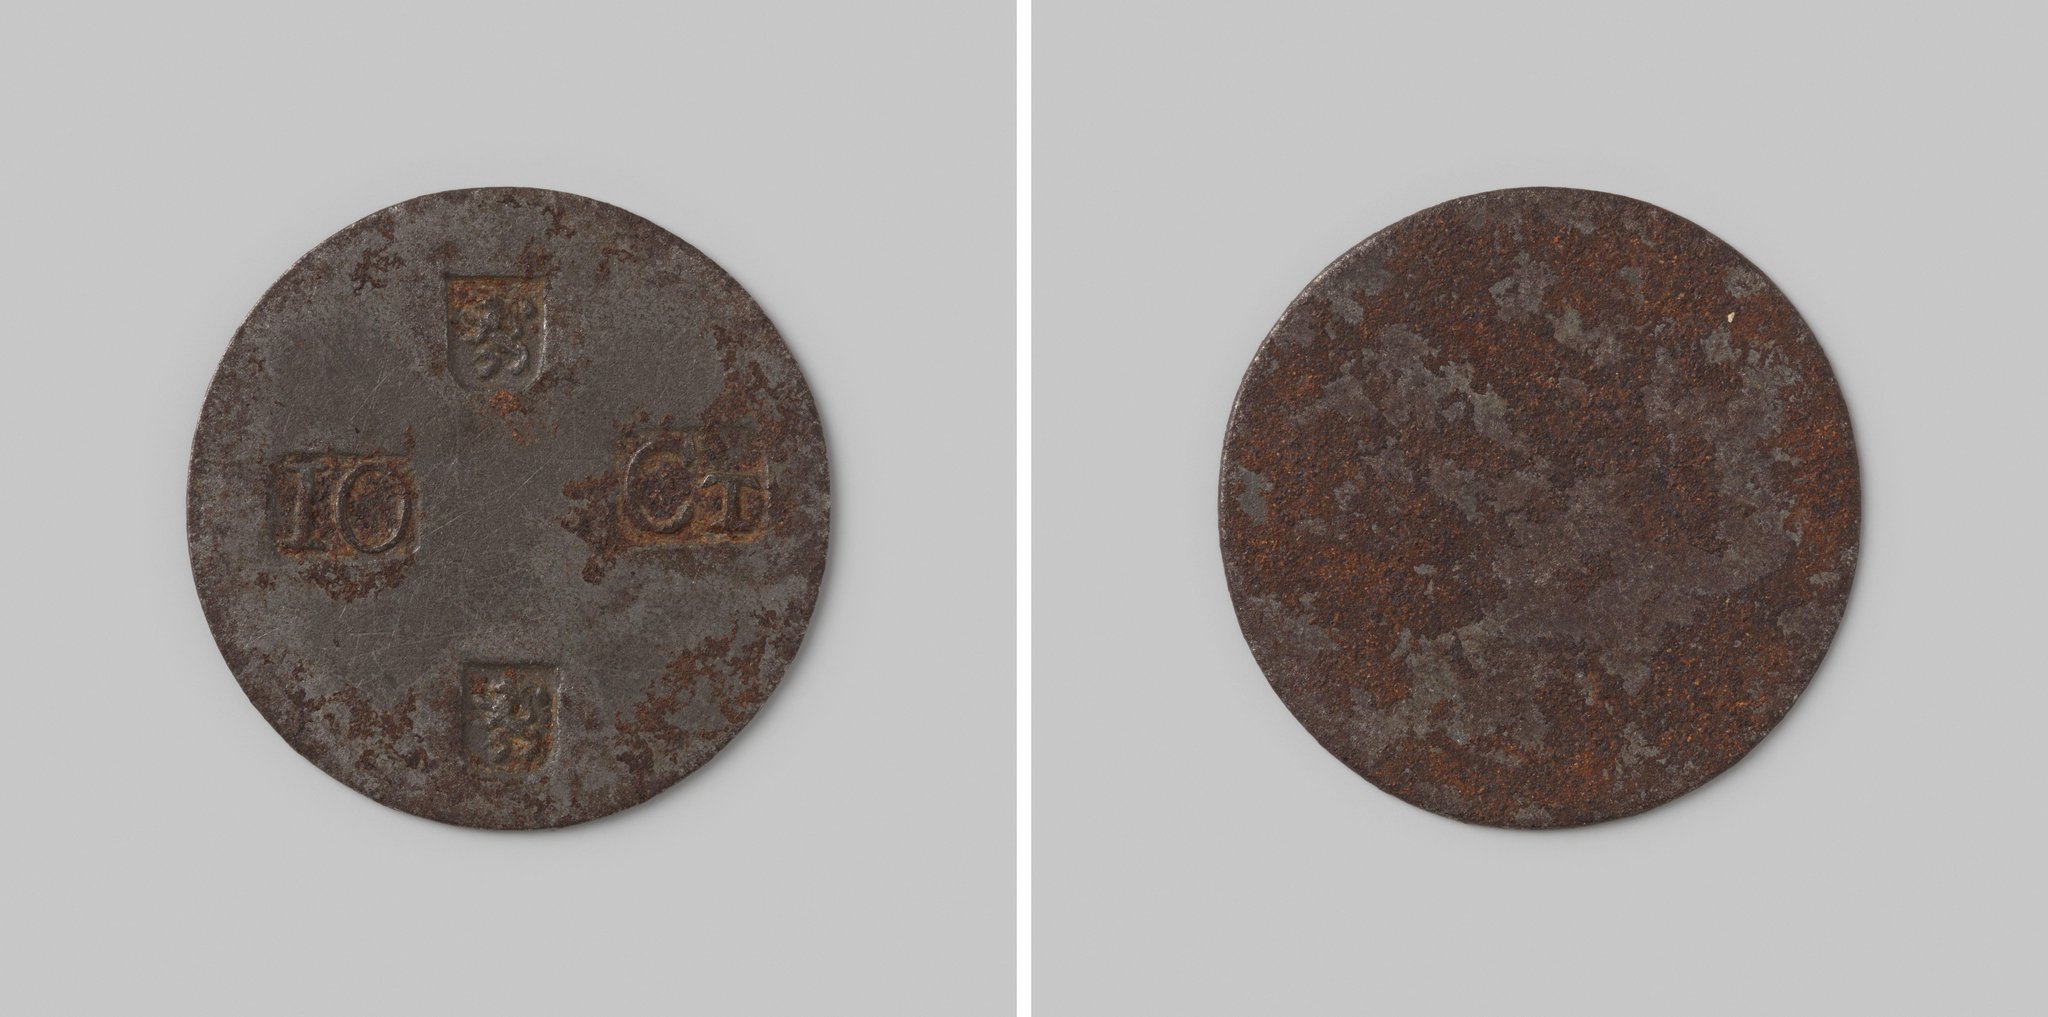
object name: tien cent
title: Betaalpenning (huismunt) met een waarde van tien cent, voor strafgevangenis Leeuwarden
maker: Anonymous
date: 1824-1847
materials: iron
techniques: printing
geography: leeuwarden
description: Ronde blikken schijf met vier instempelingen.